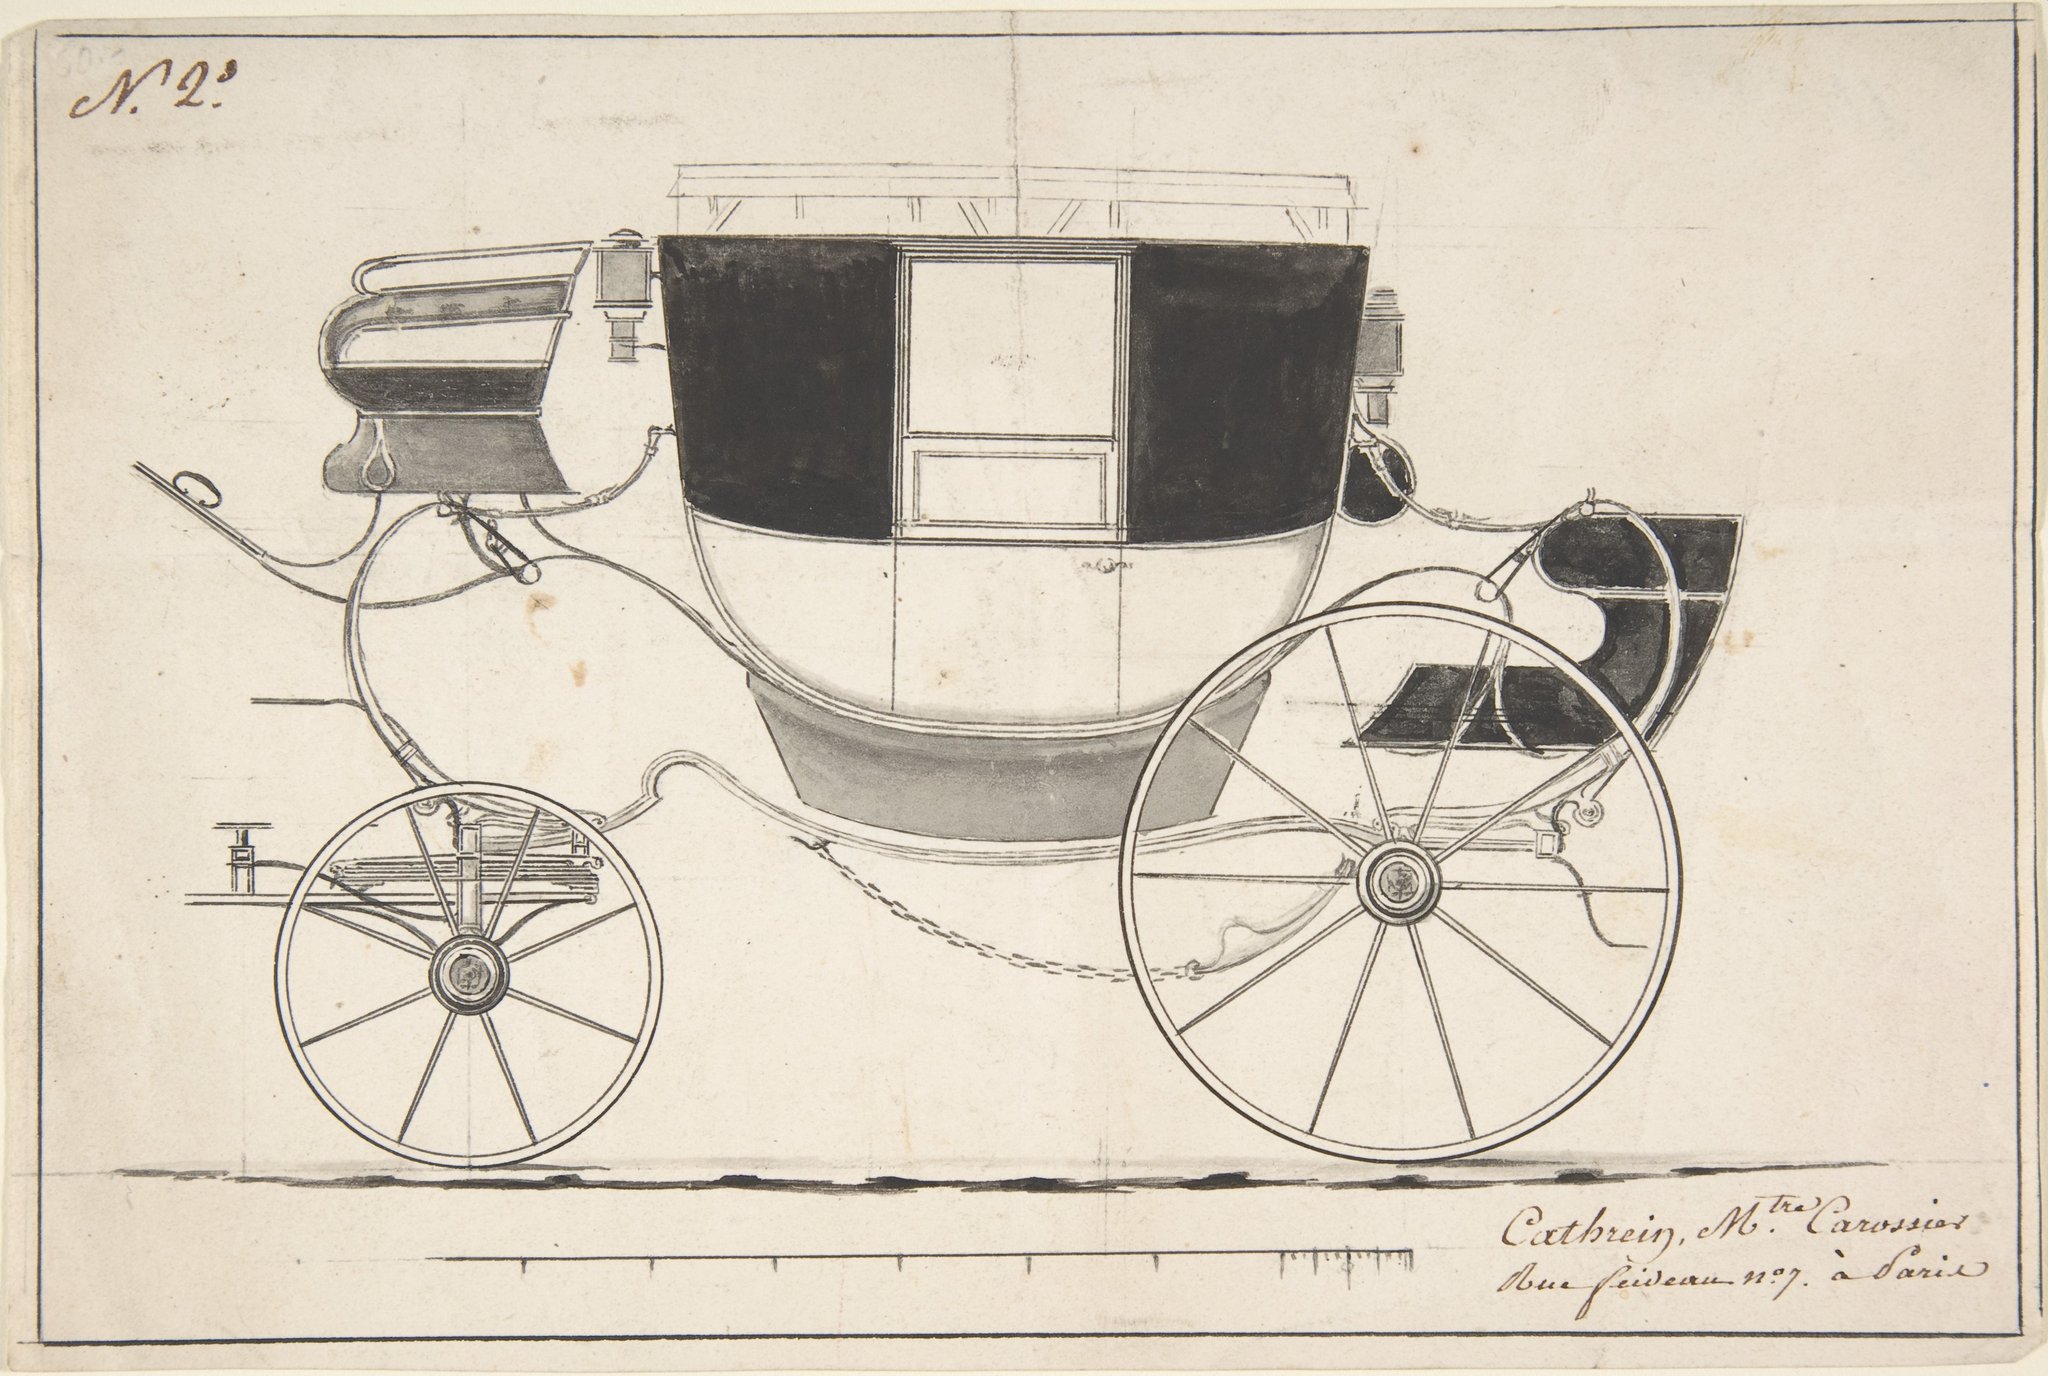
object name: drawing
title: Design for a Carriage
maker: anonymous, french, 19th century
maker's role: artist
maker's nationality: french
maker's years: 1800-1900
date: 1801-1900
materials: graphite, ink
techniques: brush, pen, wash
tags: carriages